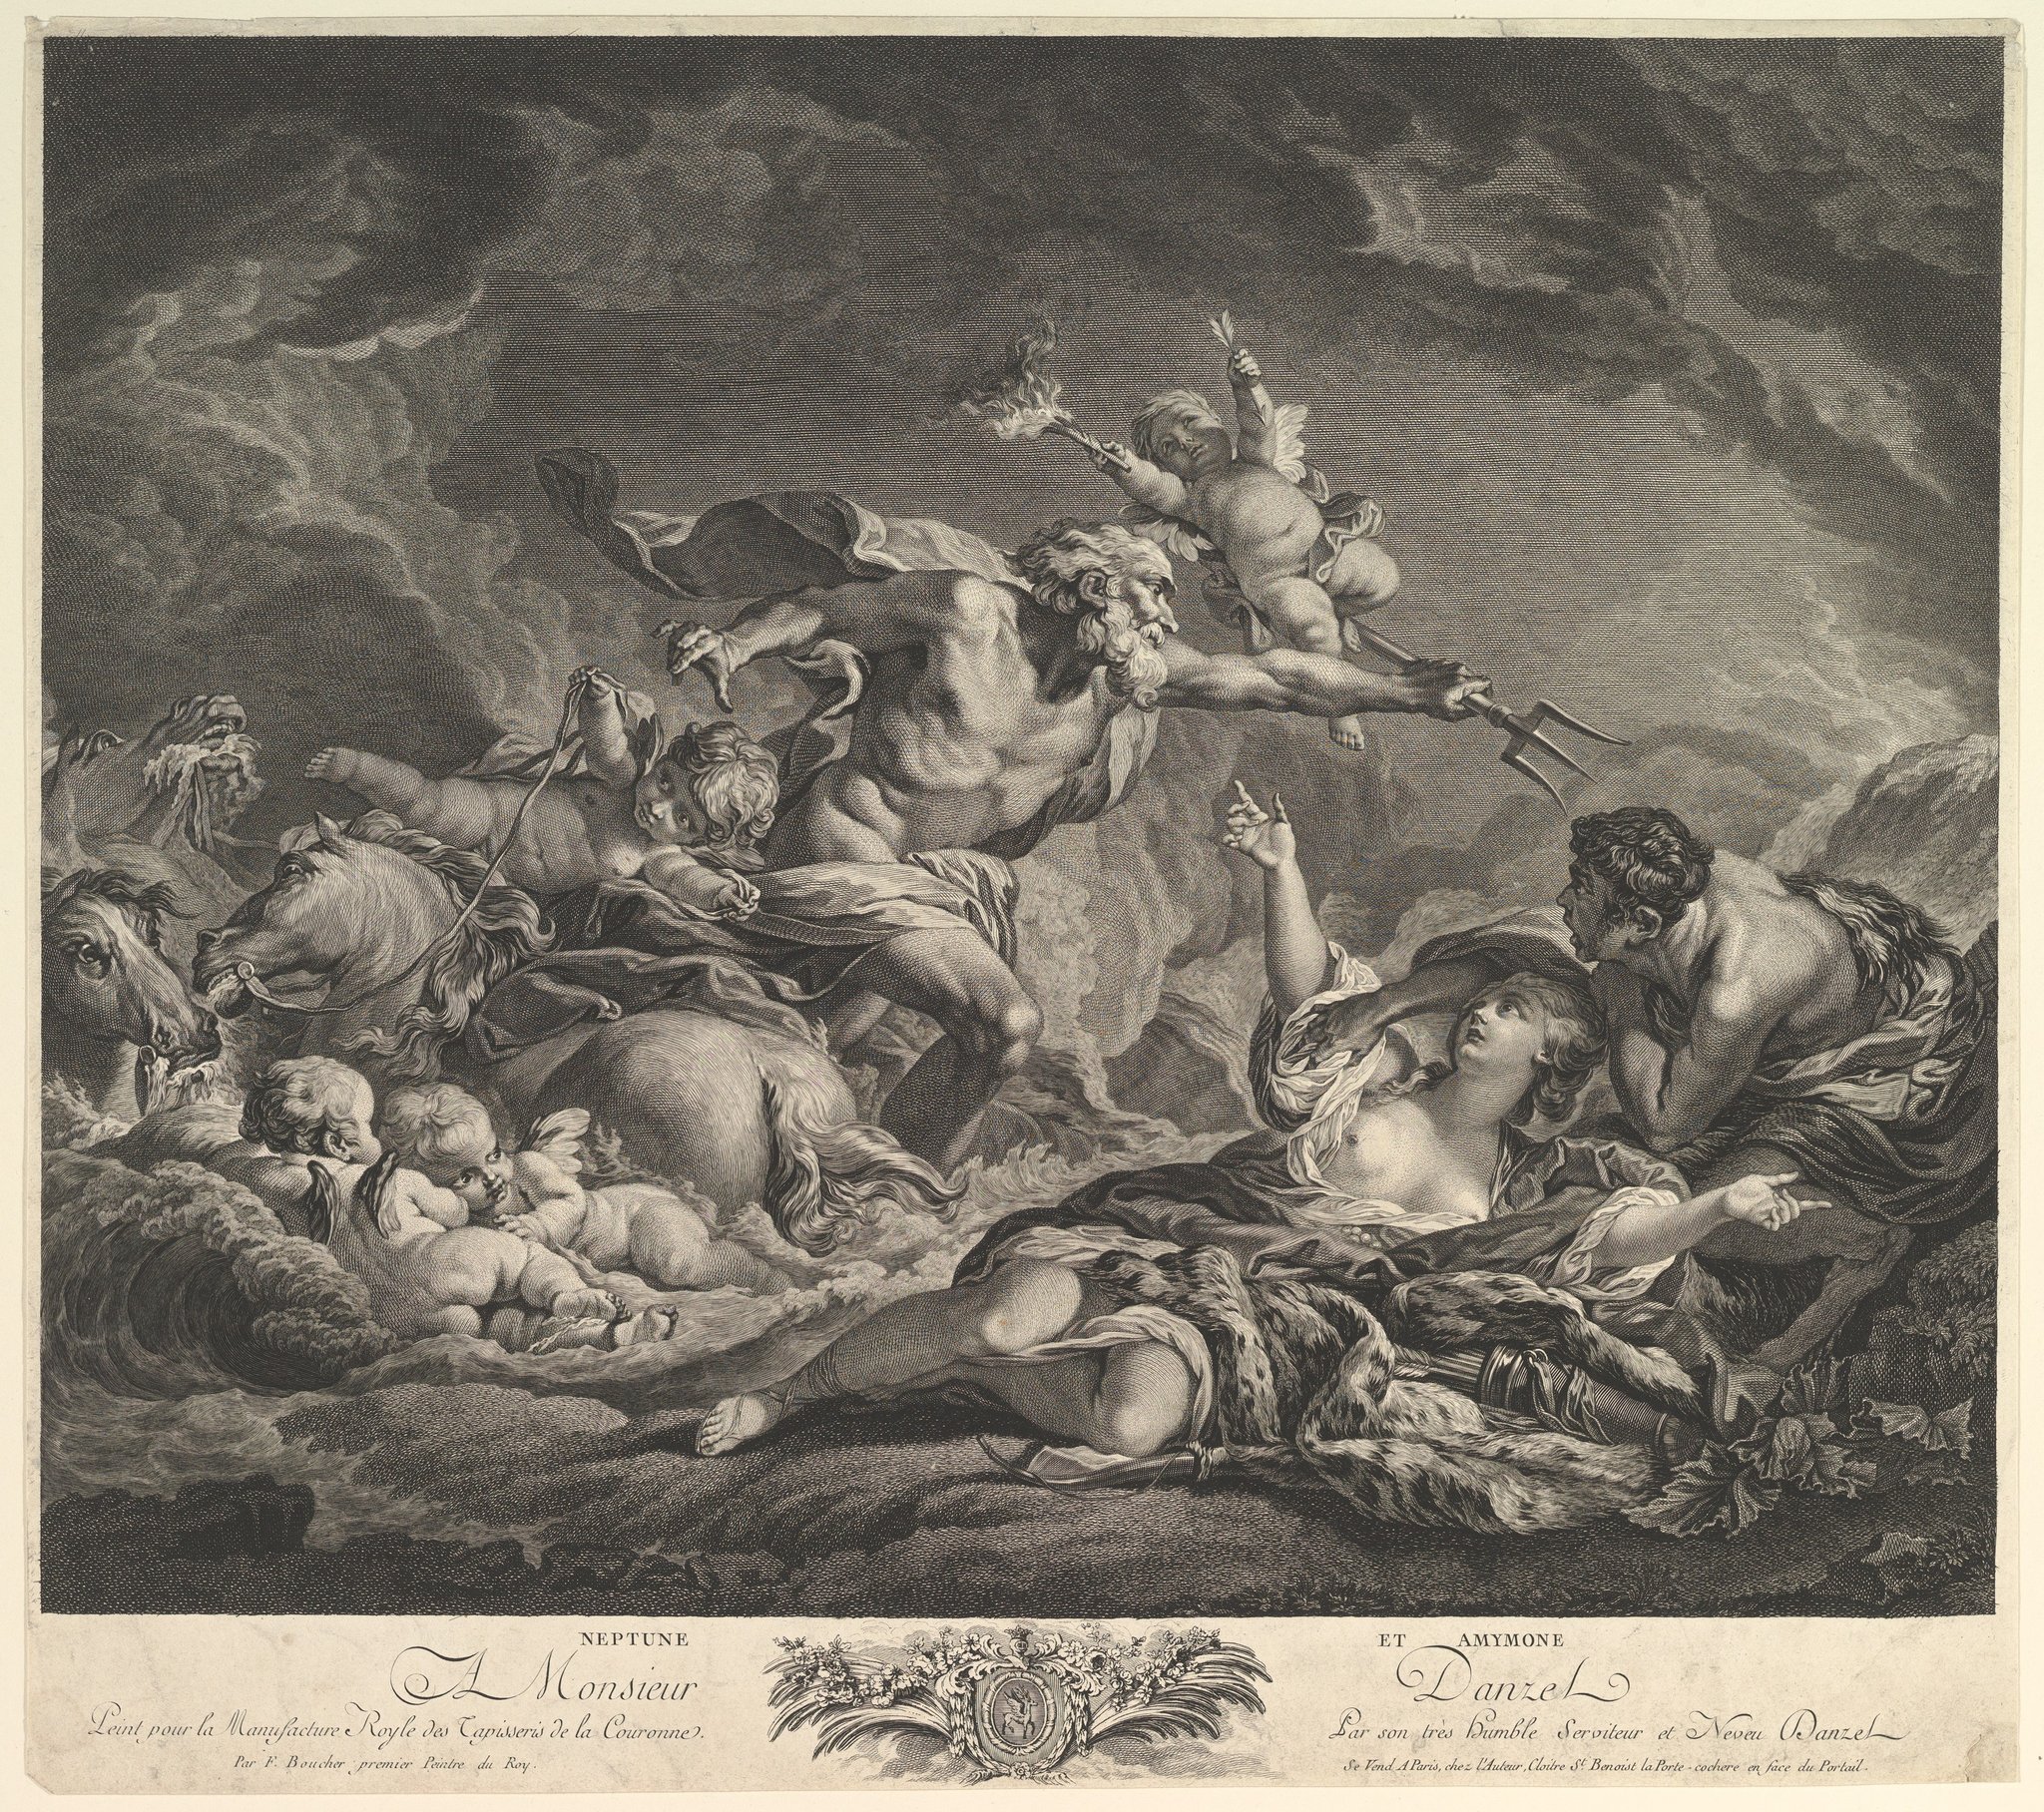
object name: print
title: Neptune and Amymone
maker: jean claude danzel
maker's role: artist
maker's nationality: french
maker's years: 1737-1809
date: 1701-1800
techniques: engraving, etching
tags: women,putti,neptune,horses